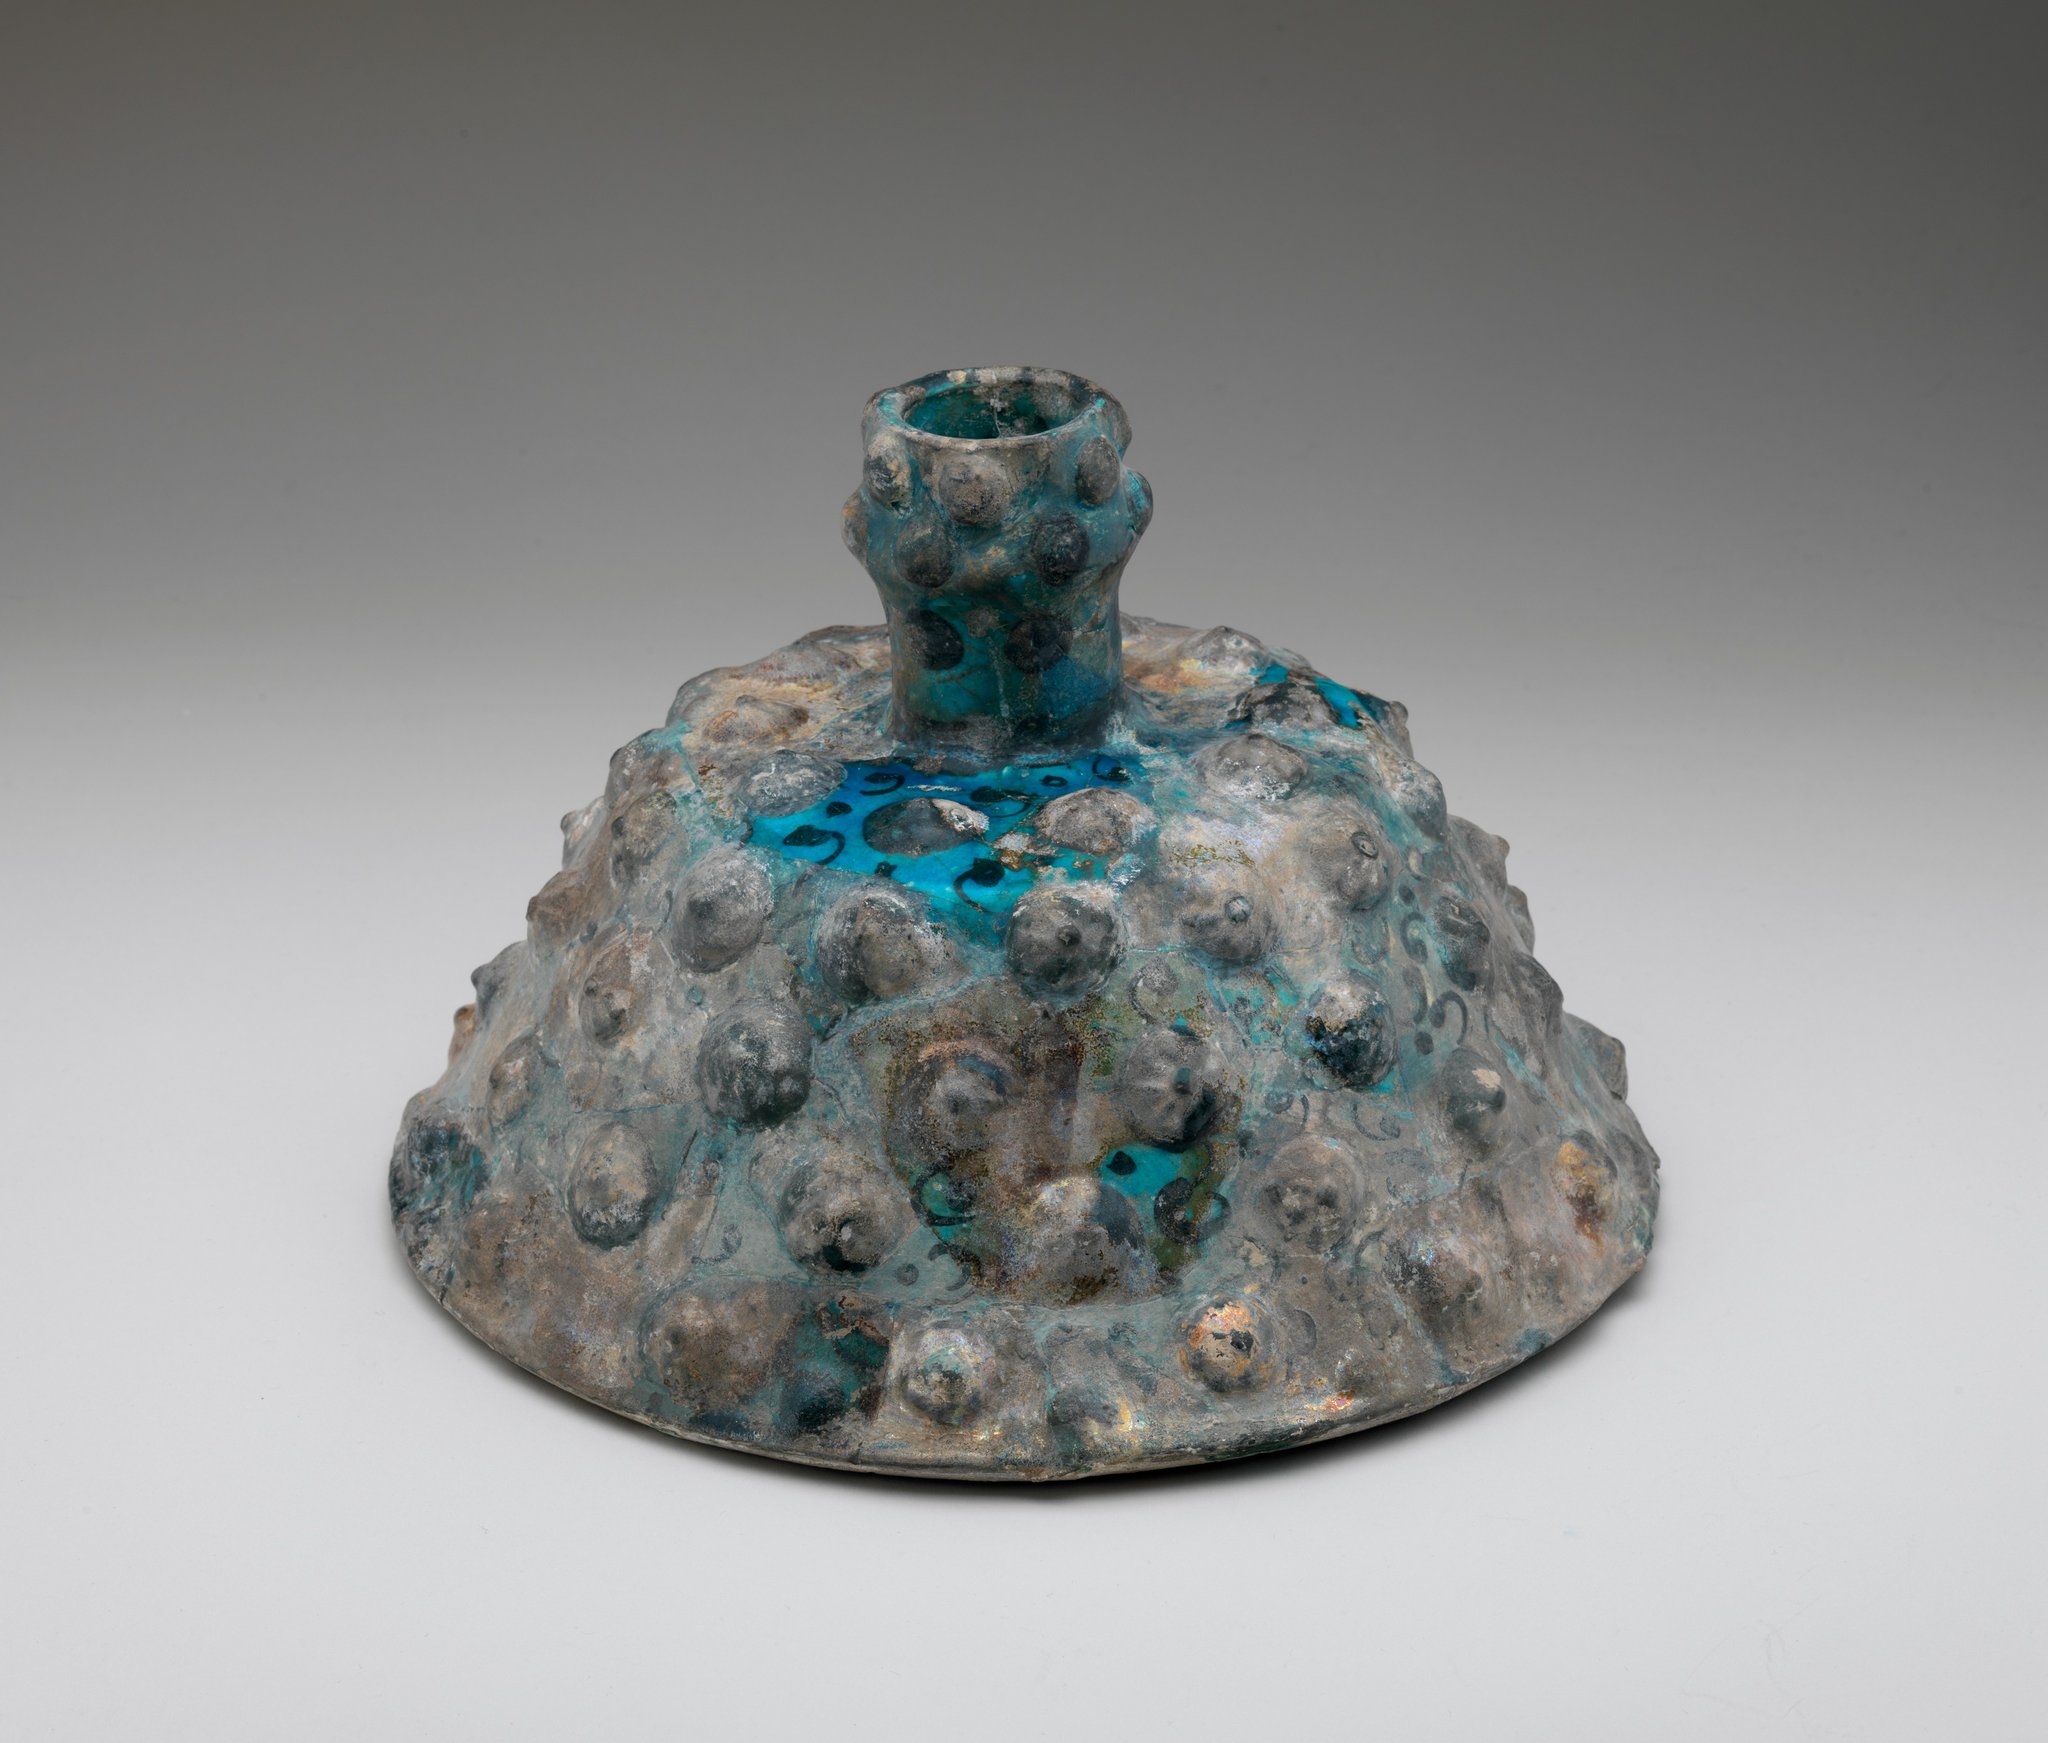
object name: candlestick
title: Embossed Candlestick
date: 1101-1200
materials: glaze, stonepaste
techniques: painting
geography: iran